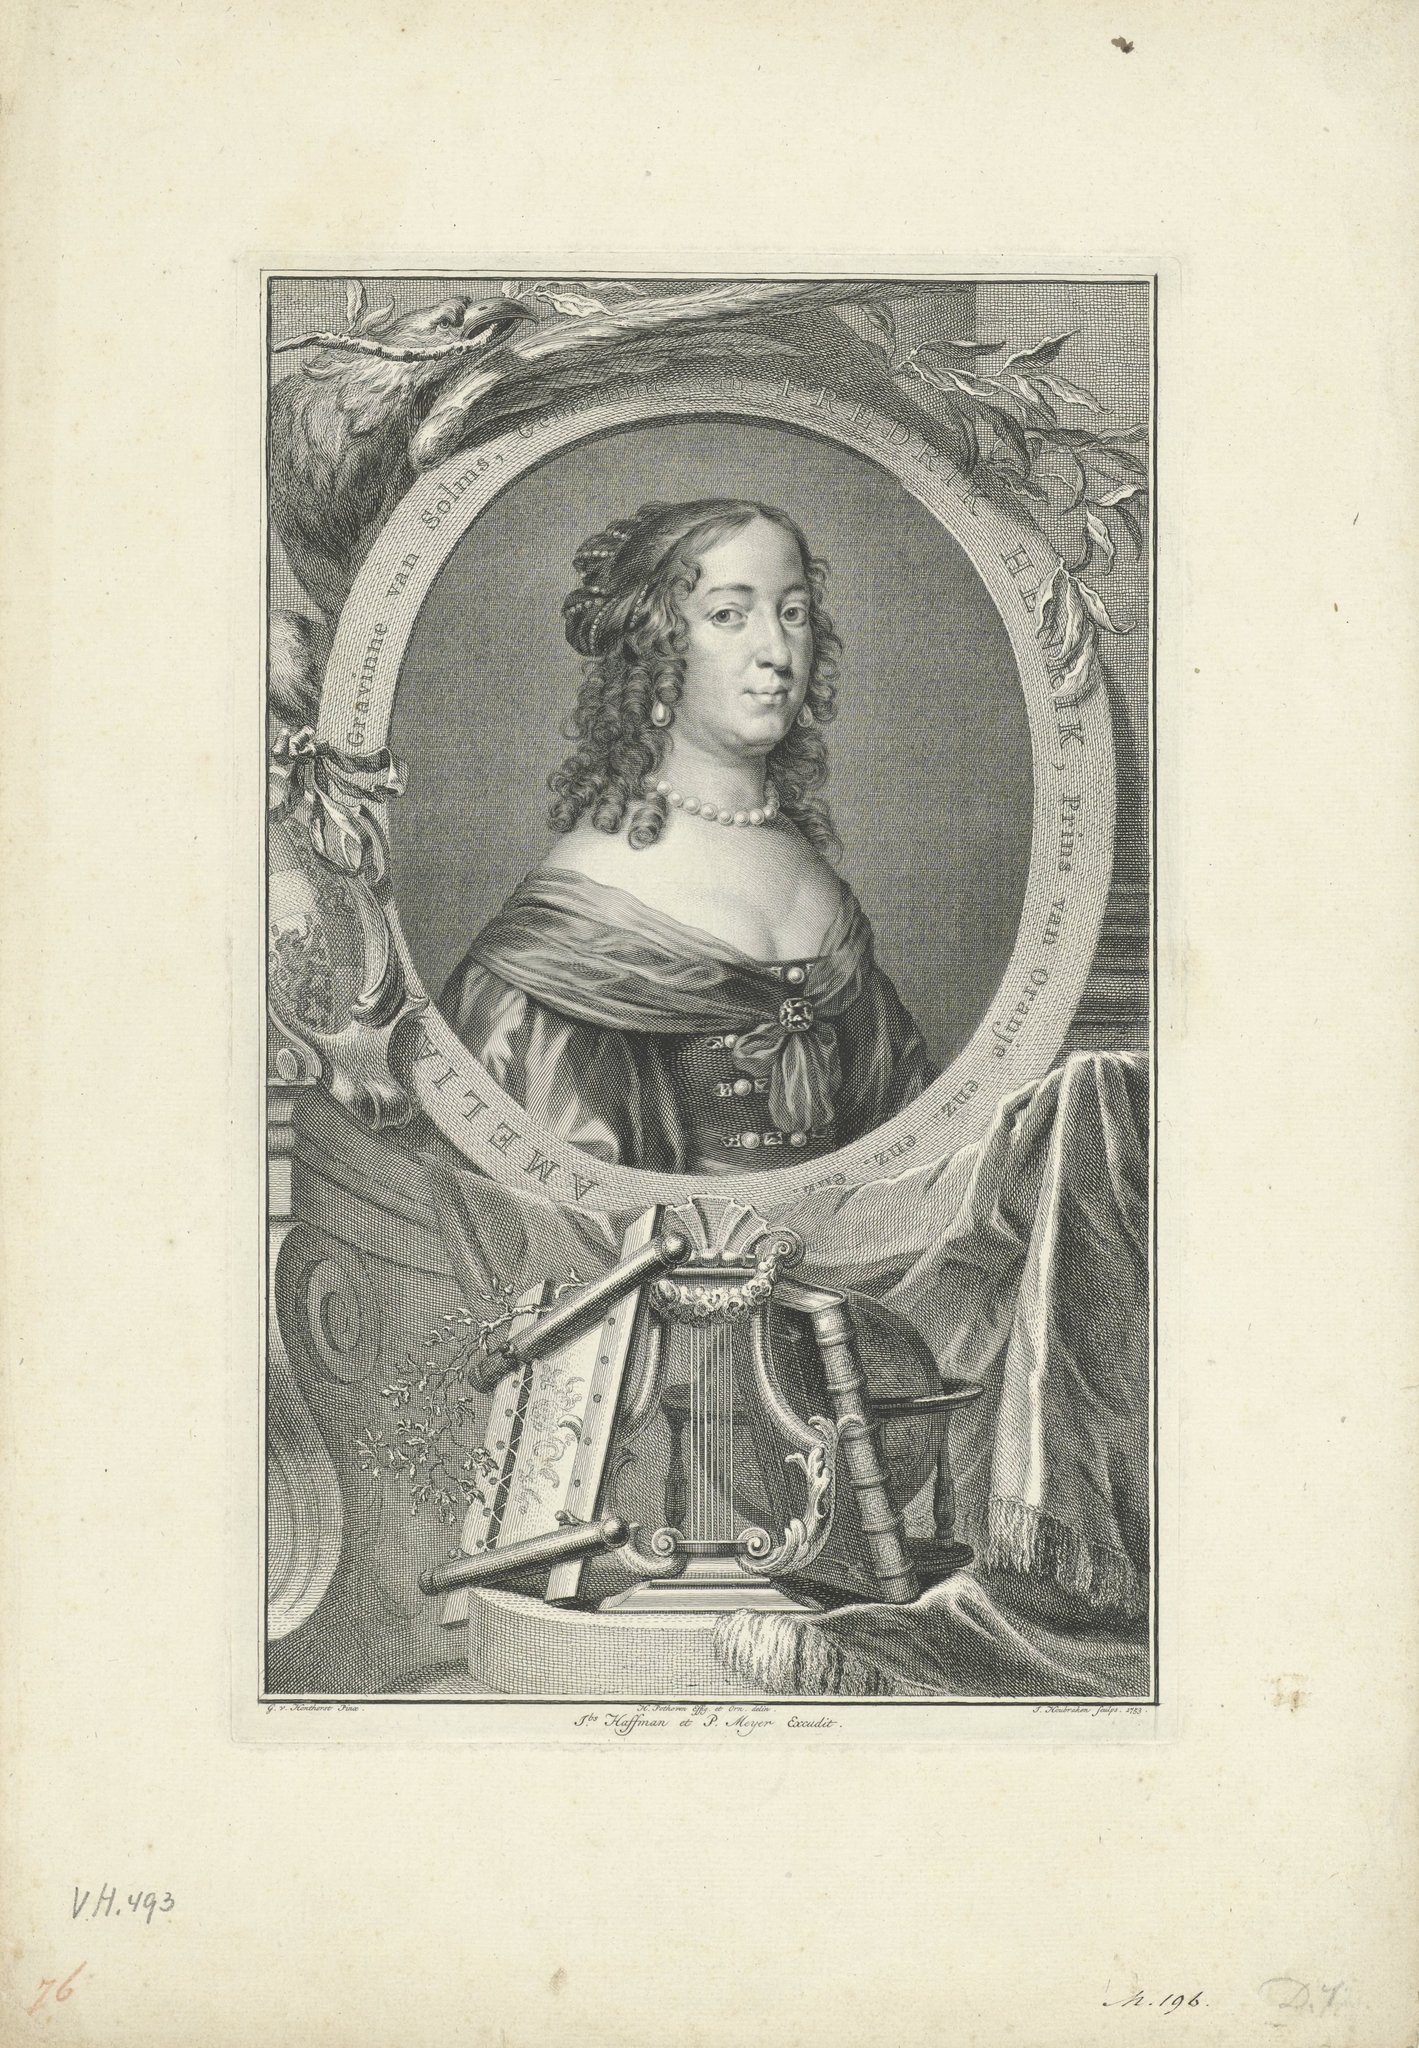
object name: print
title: Gemalinnen en moeders der stadhouderen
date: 1753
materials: paper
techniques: engraving, etching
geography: amsterdam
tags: the hague, amalia of solms-braunfels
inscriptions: number: ‘n. 196.’, inscription: ‘Verkocht vlg Resol 13 Oct. 76. [...] Gemeente Archivaris’, collector's mark: Lugt 2228, stamp: ‘archief der stad Utrecht’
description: Portret van Amalia van Solms, echtgenote van Frederik Hendrik. Vierde prent uit een serie van zes met de afbeeldingen van de gemalinnen en moeders van de stadhouders.